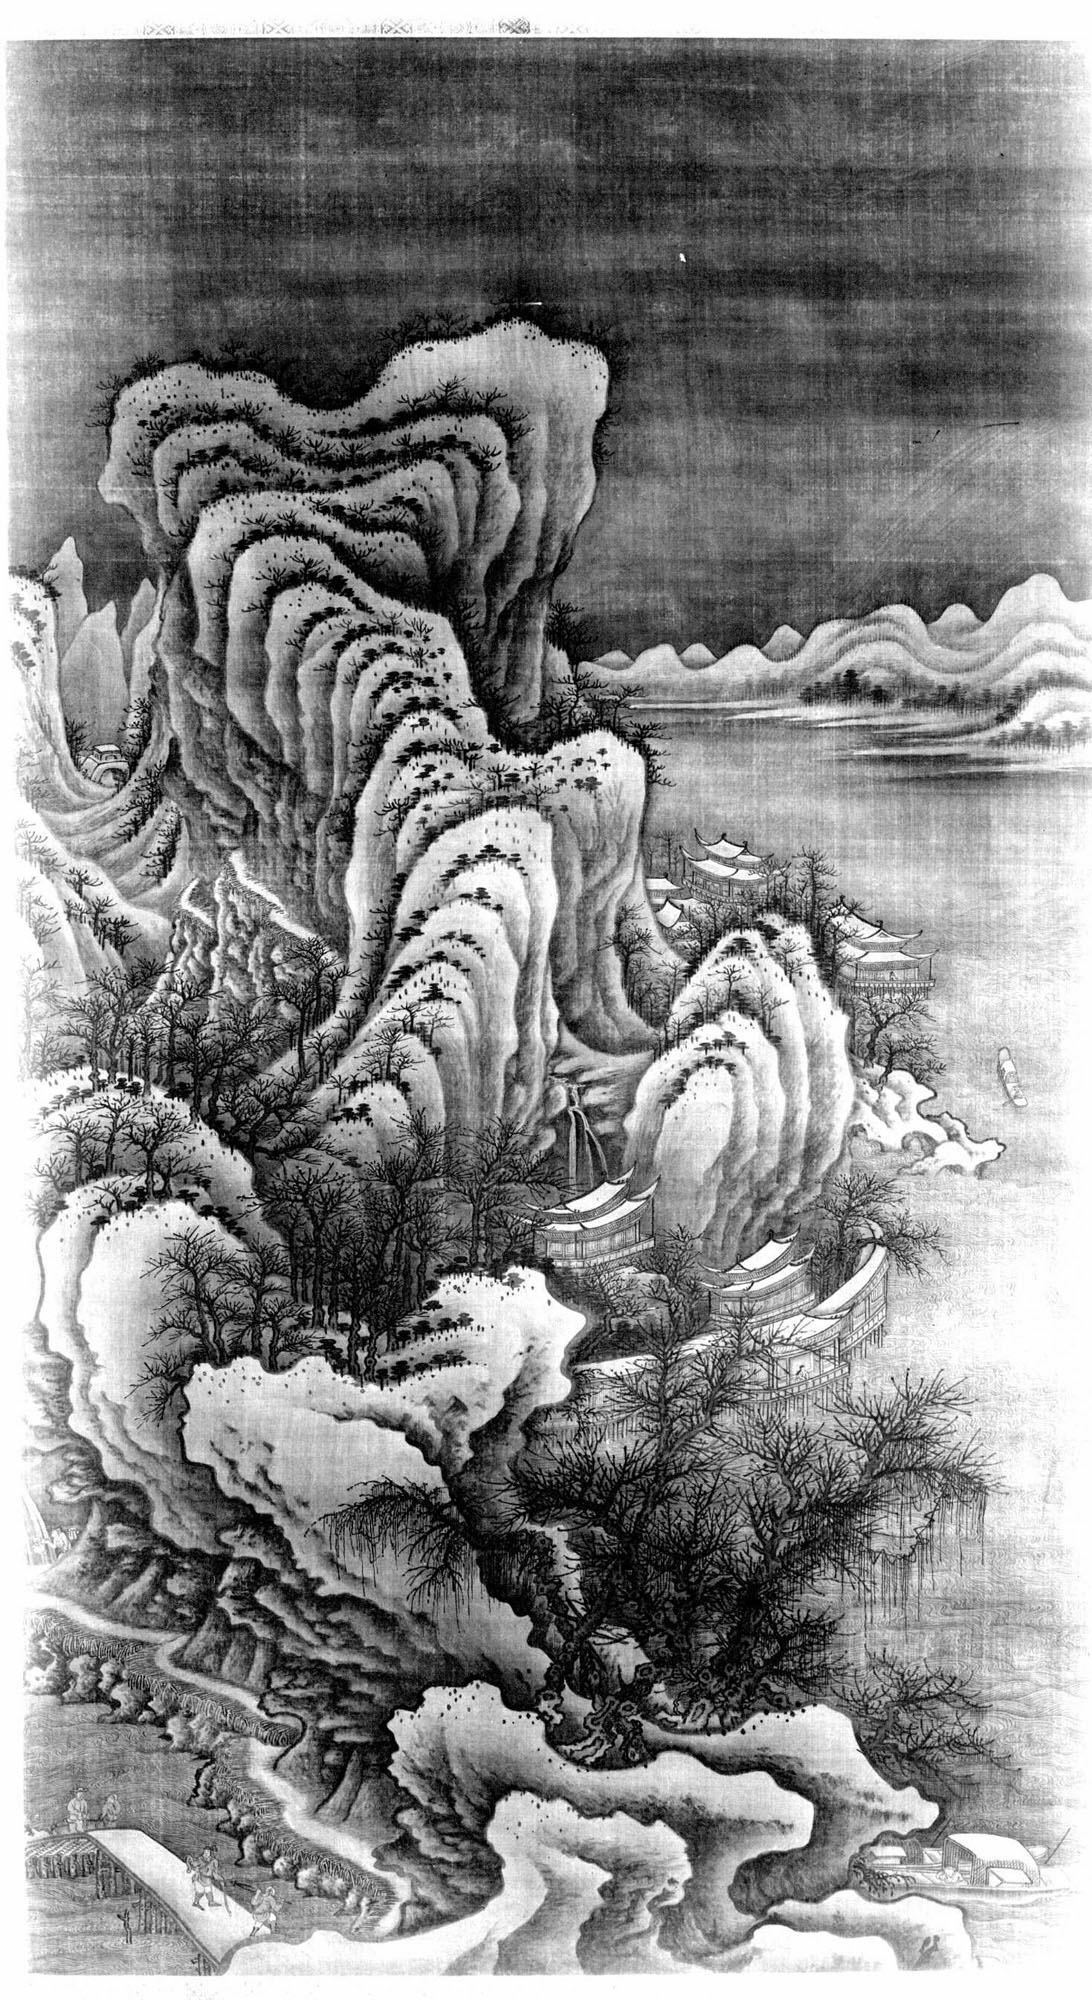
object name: hanging scroll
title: Mountain Wayfarers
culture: chinese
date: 1644-1911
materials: ink, silk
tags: mountains,landscapes